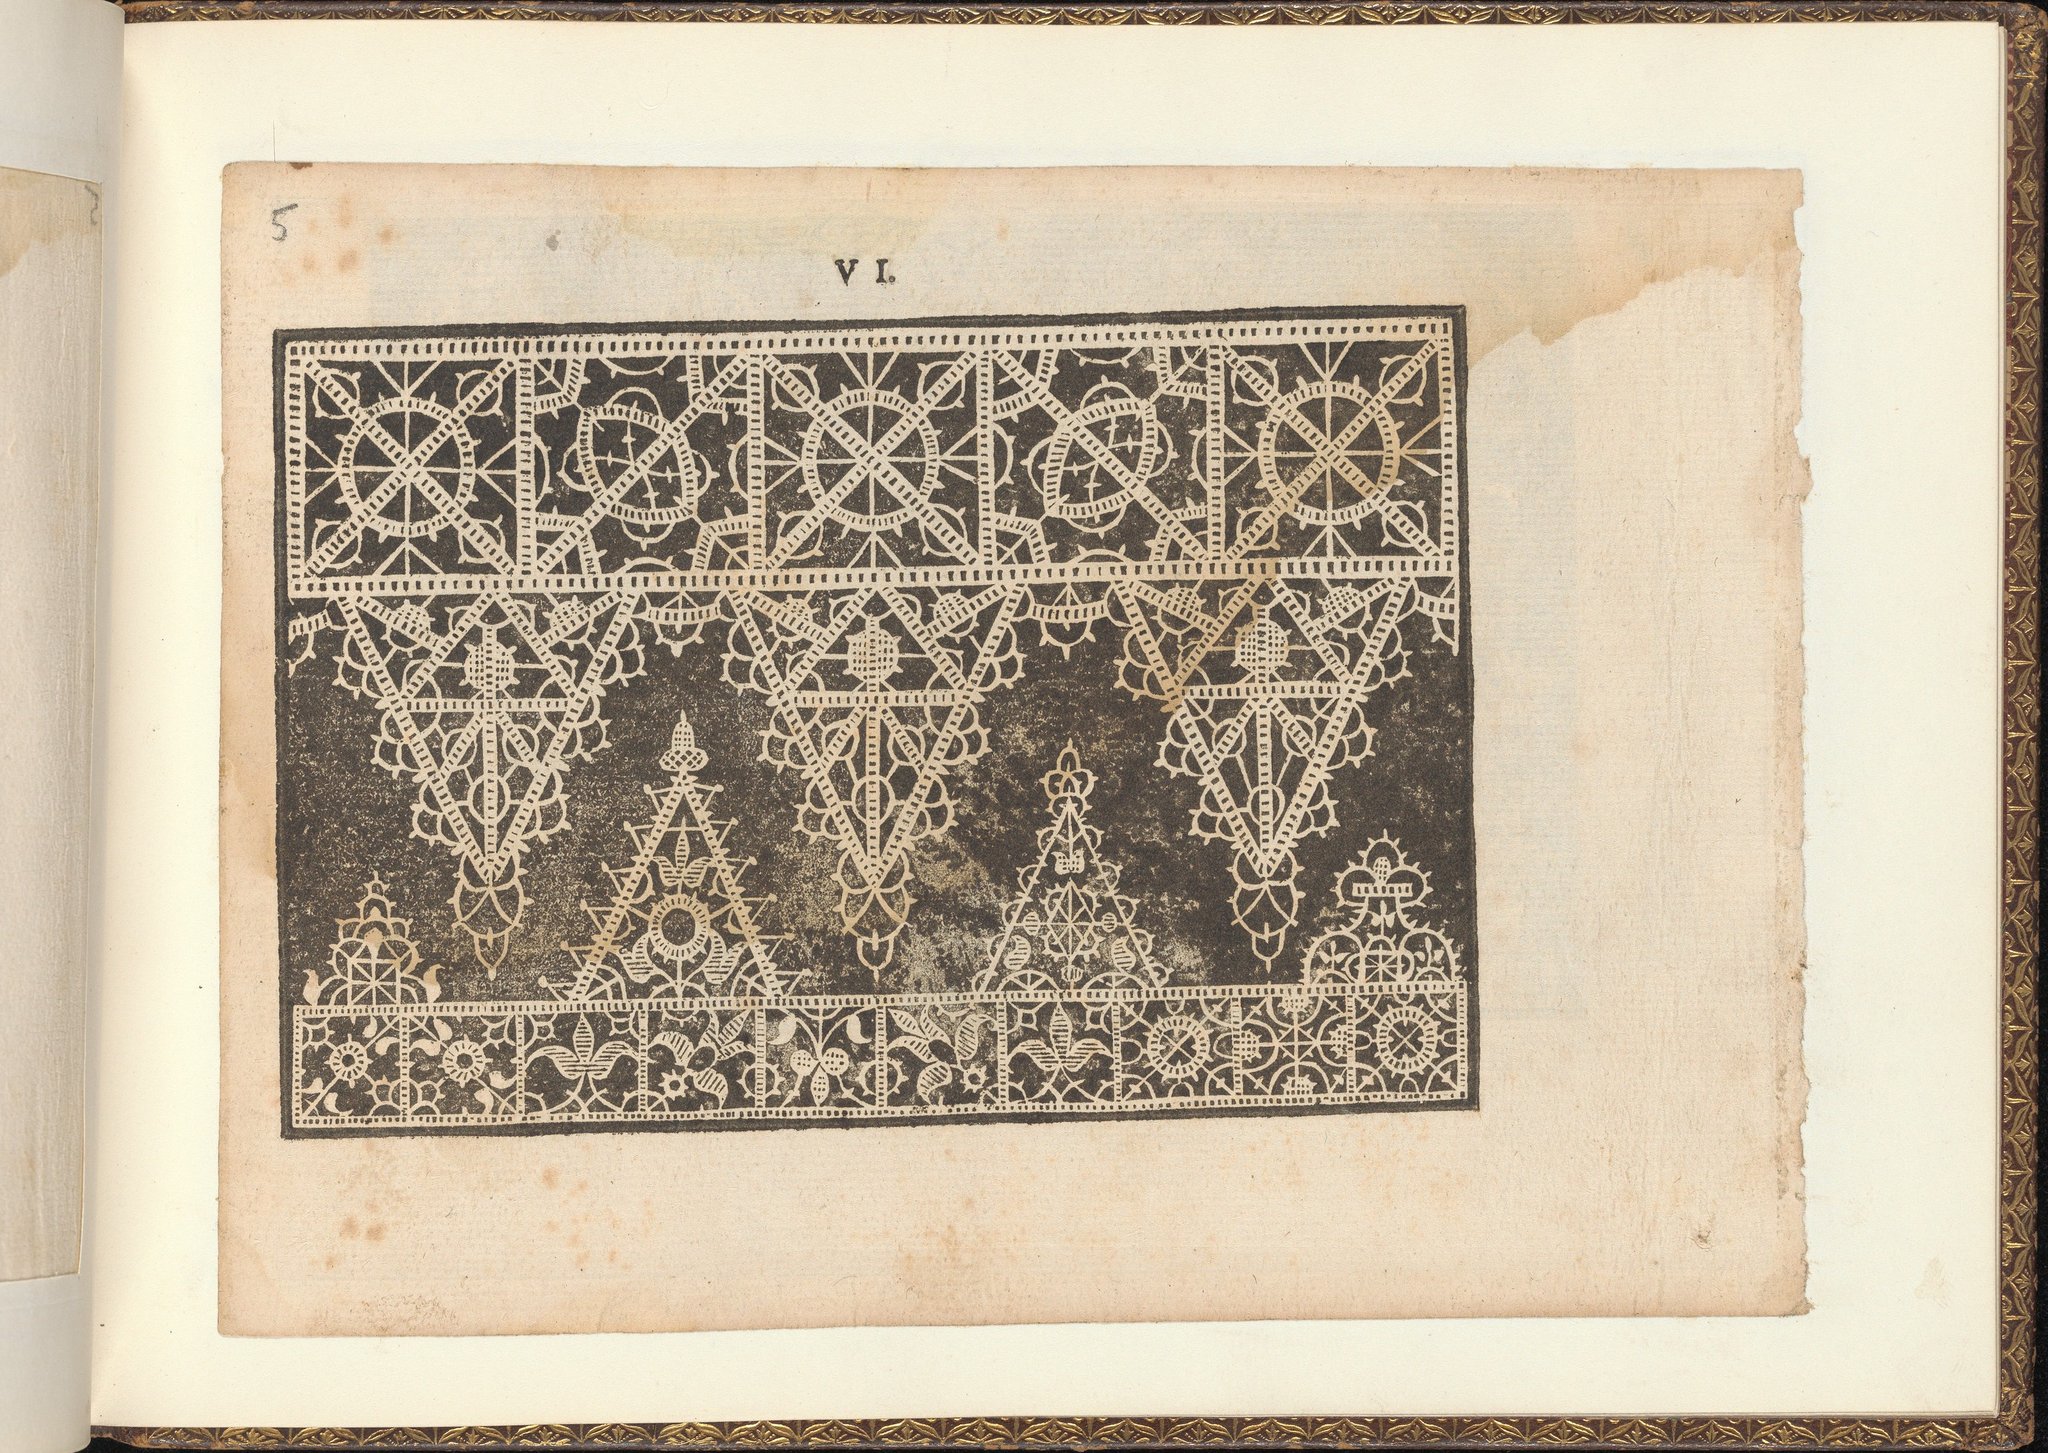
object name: book print ornament architecture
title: Prima parte de' fiori, page 6 (recto)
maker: giovanni battista ciotti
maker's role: author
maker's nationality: italian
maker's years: 1555-1659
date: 1591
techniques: woodcut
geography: italy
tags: ornament